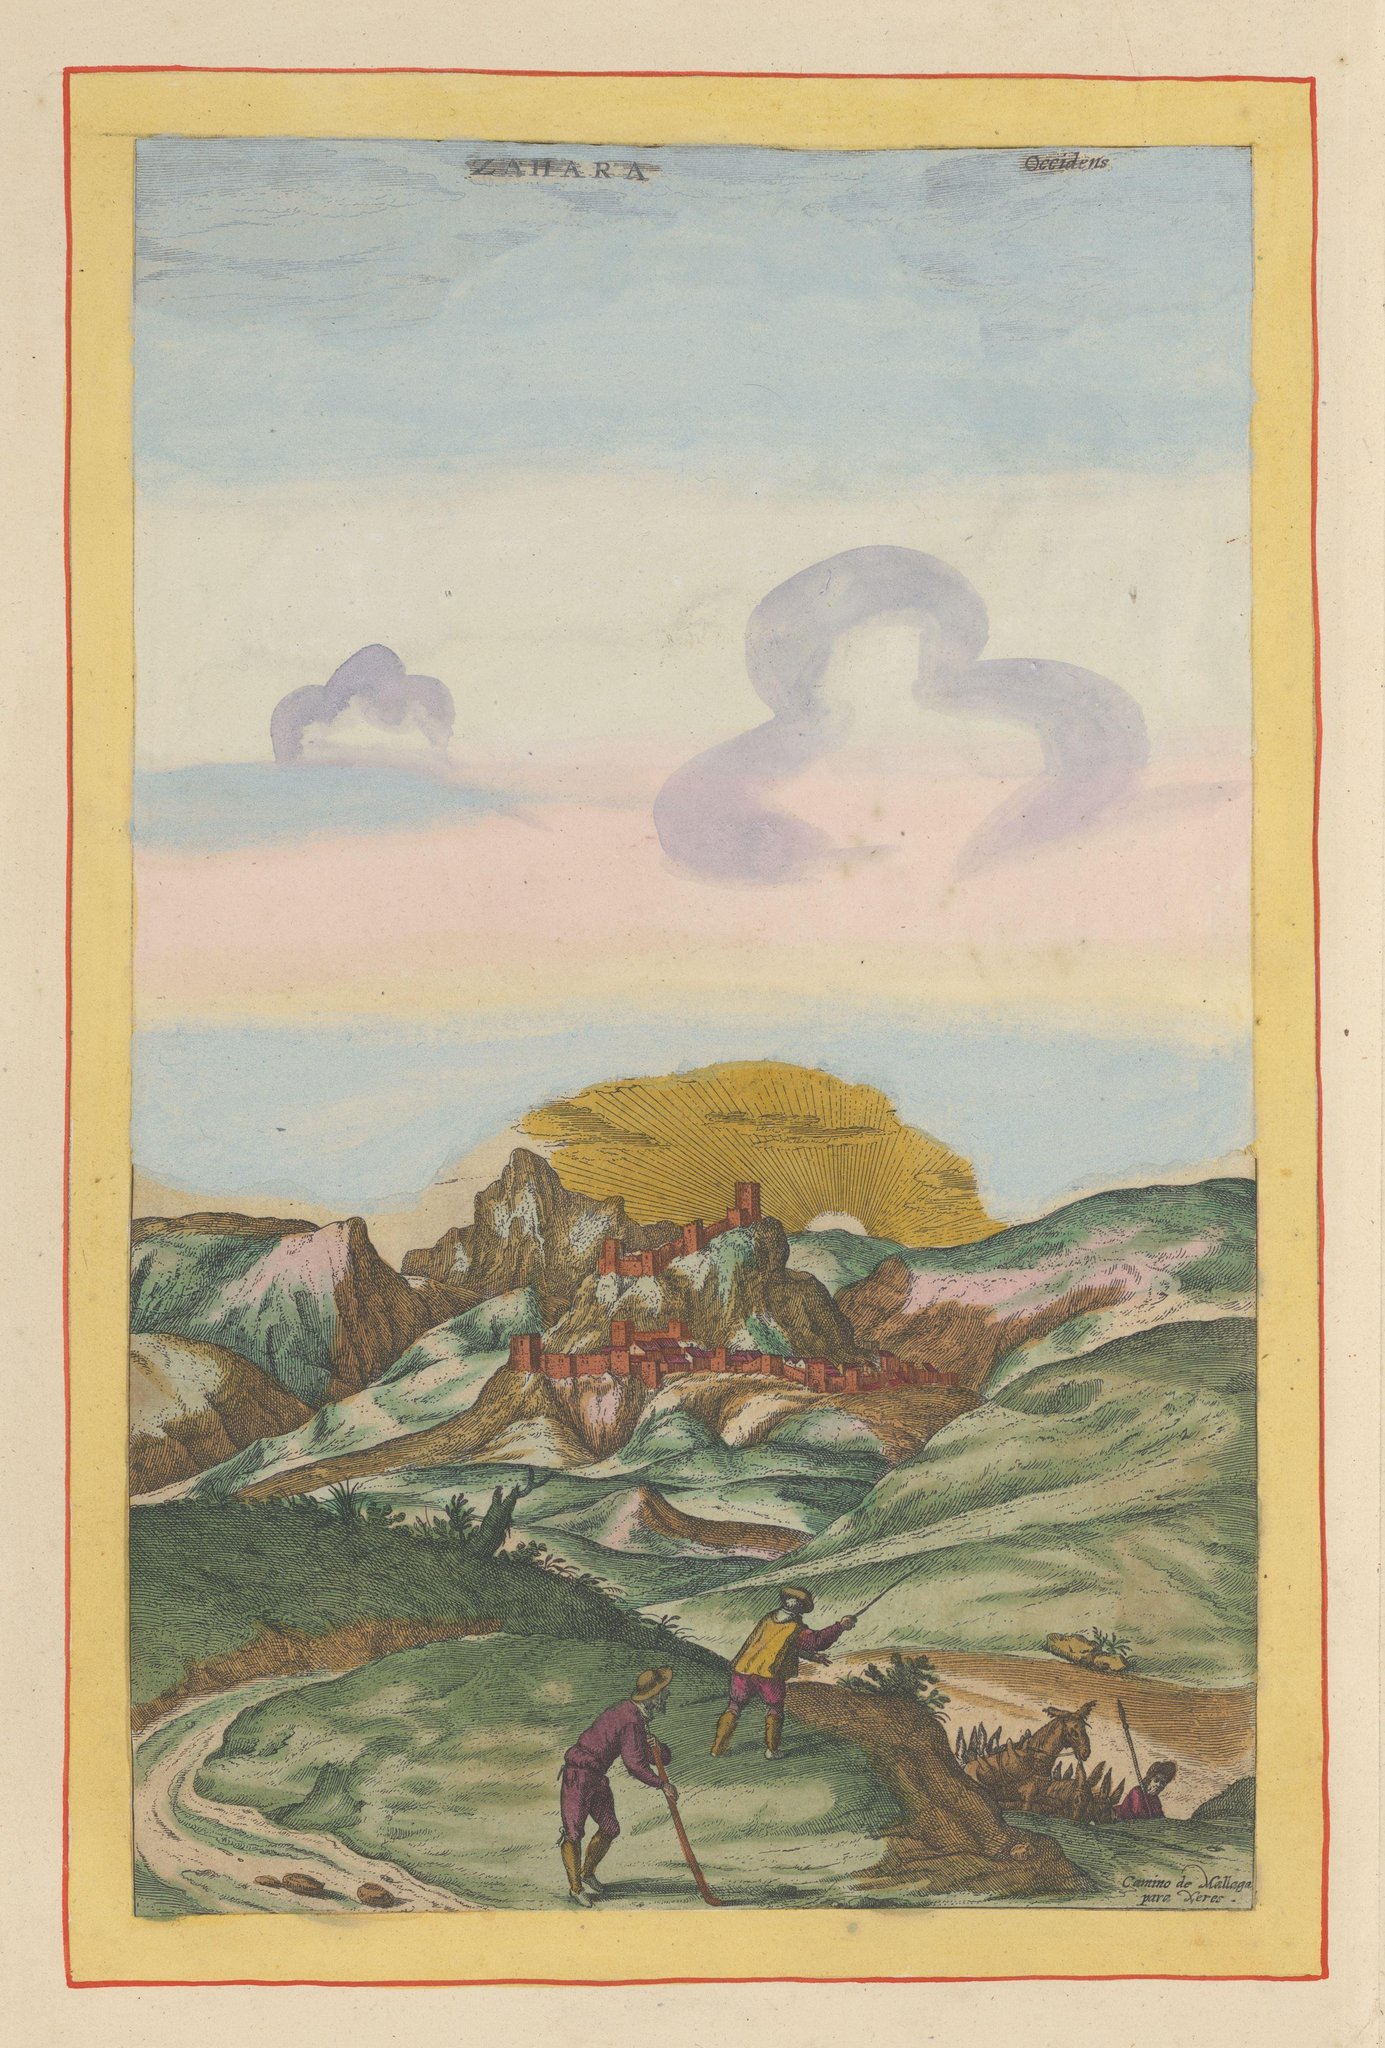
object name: print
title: Gezicht op de plaats Zahara de la Sierra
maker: anna beeck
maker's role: publisher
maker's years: 1657-1717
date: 1596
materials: paper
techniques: engraving, etching, hand coloring, letterpress printing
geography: the hague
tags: prospect of village, silhouette of village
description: Prent origineel vervaardigd als boekillustratie voor: Georg Braun en Frans Hogenberg. Civitates Orbis Terrarum, 6 delen. Keulen: 1572-1617. De prent werd voor het eerst gepubliceerd in deel 5: Urbium praecipuarum mundi theatrum quintum, 1596. De prent is langs de bovenrand van de heuvels afgescheurd. Het bovenste gedeelte met de lucht is hoger opgeplakt, zodat de lucht hoger is geworden en het formaat van de voorstelling past bij de andere groot formaatvoorstellingen in het album.